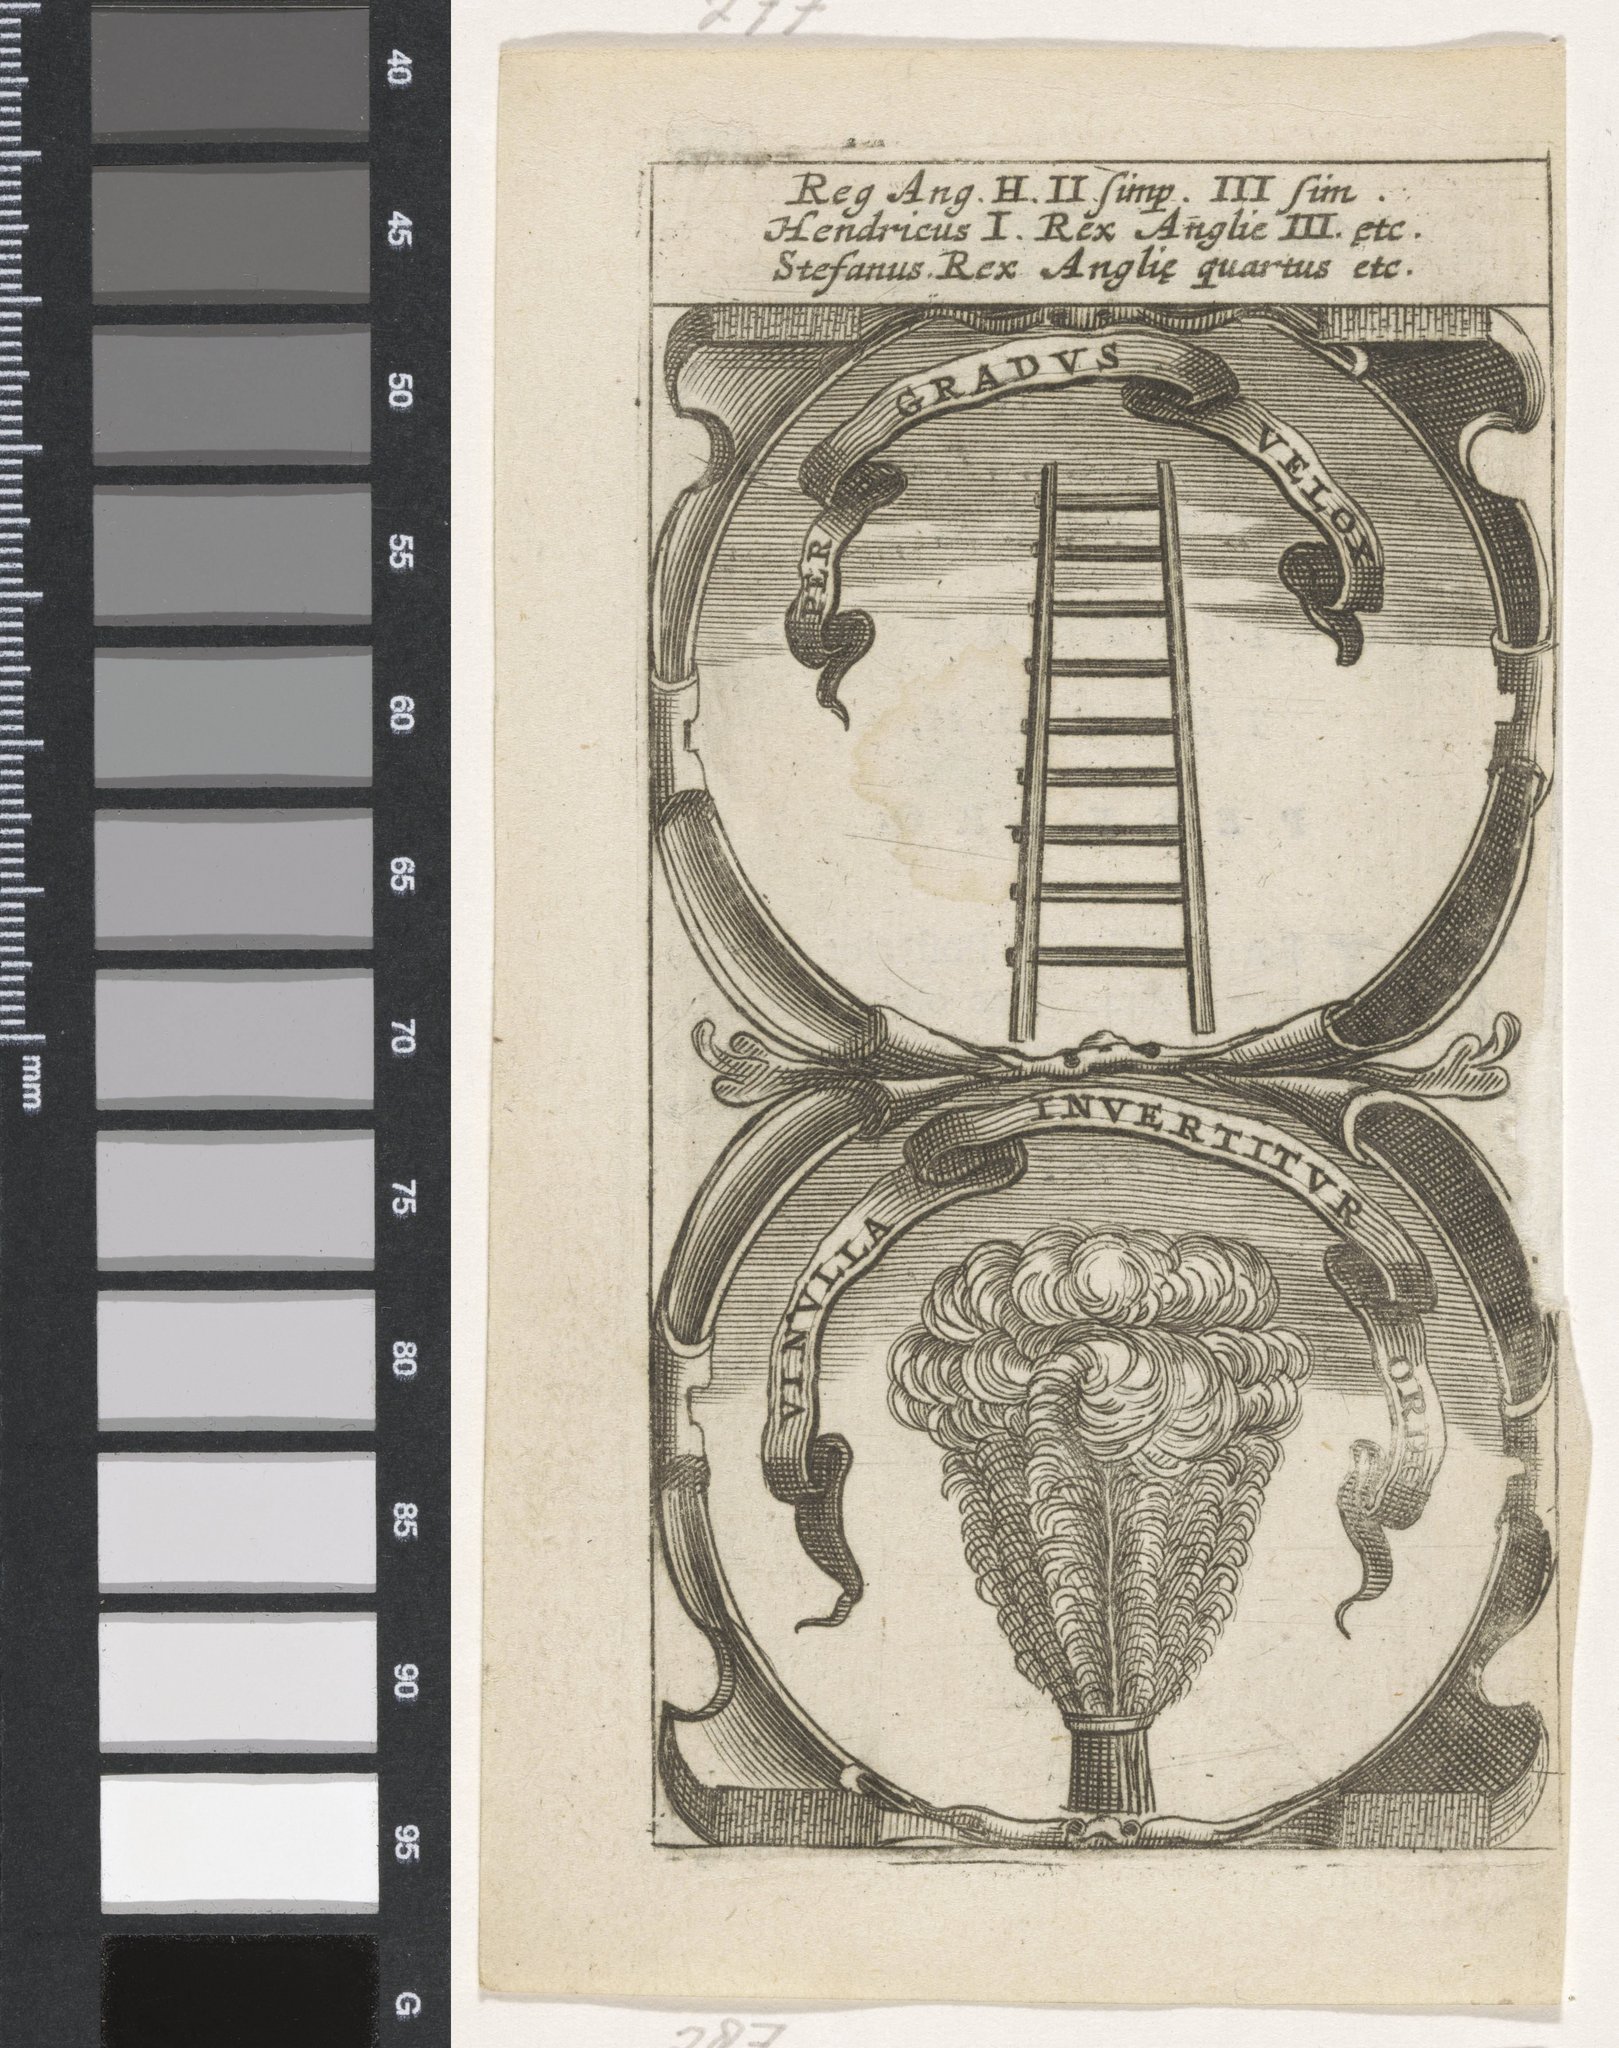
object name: book illustration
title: Symbola Divina et Humana Pontificum Imperatorum Regum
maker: Anonymous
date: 1666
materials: paper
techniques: engraving, letterpress printing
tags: walker and runner birds: ostrich, ladder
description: Pagina uit Jacob Typotius, Symbola Divina & Humana Pontificum Imperatorum Regum. Arnhem, J.F. Hagen, 1666 of uit de titeluitgave van 1669 of 1679. Het werk van Typotius werd voor het eerst uitgegeven in 1601 met prenten van Aegidius Sadeler.